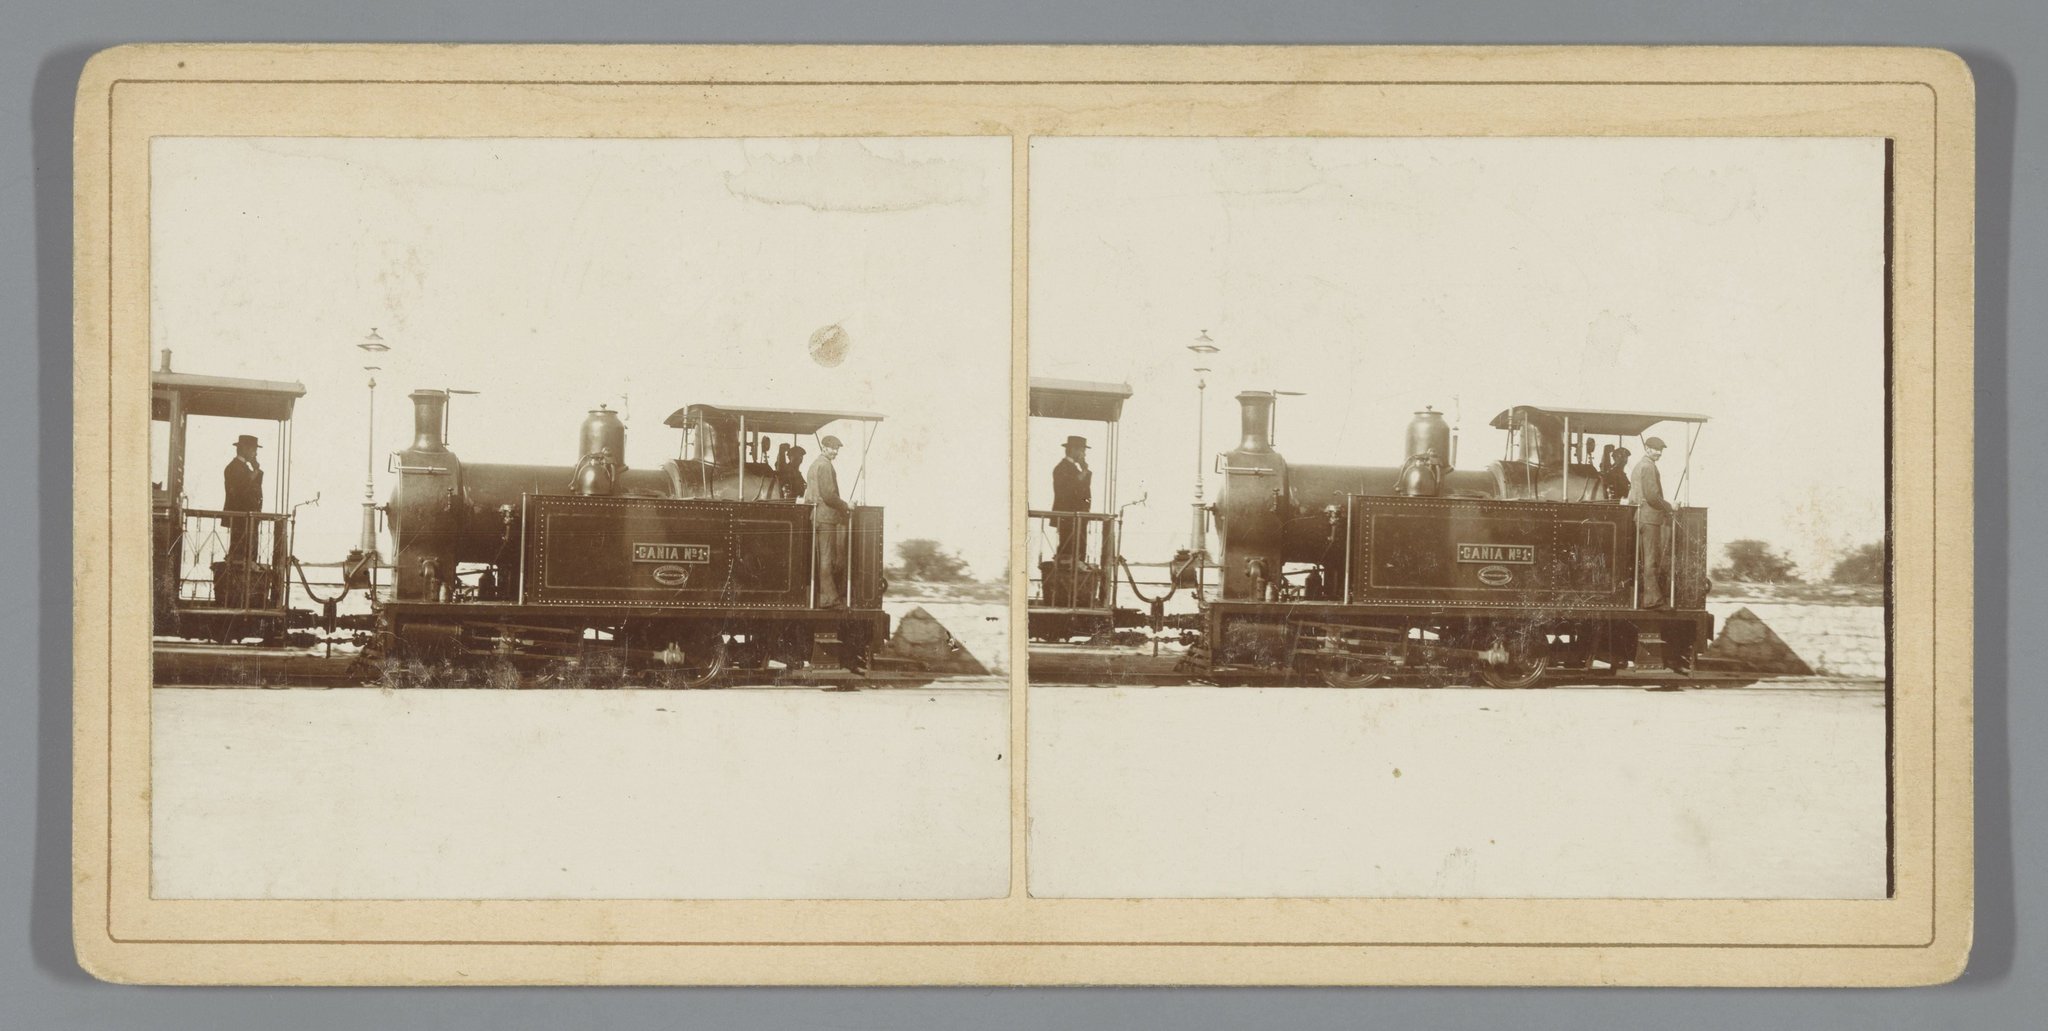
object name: stereograph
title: Stoomlocomotief Cania 1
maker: Anonymous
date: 1868-1890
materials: paper, cardboard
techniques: collodion silver print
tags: railway, train, steam locomotive